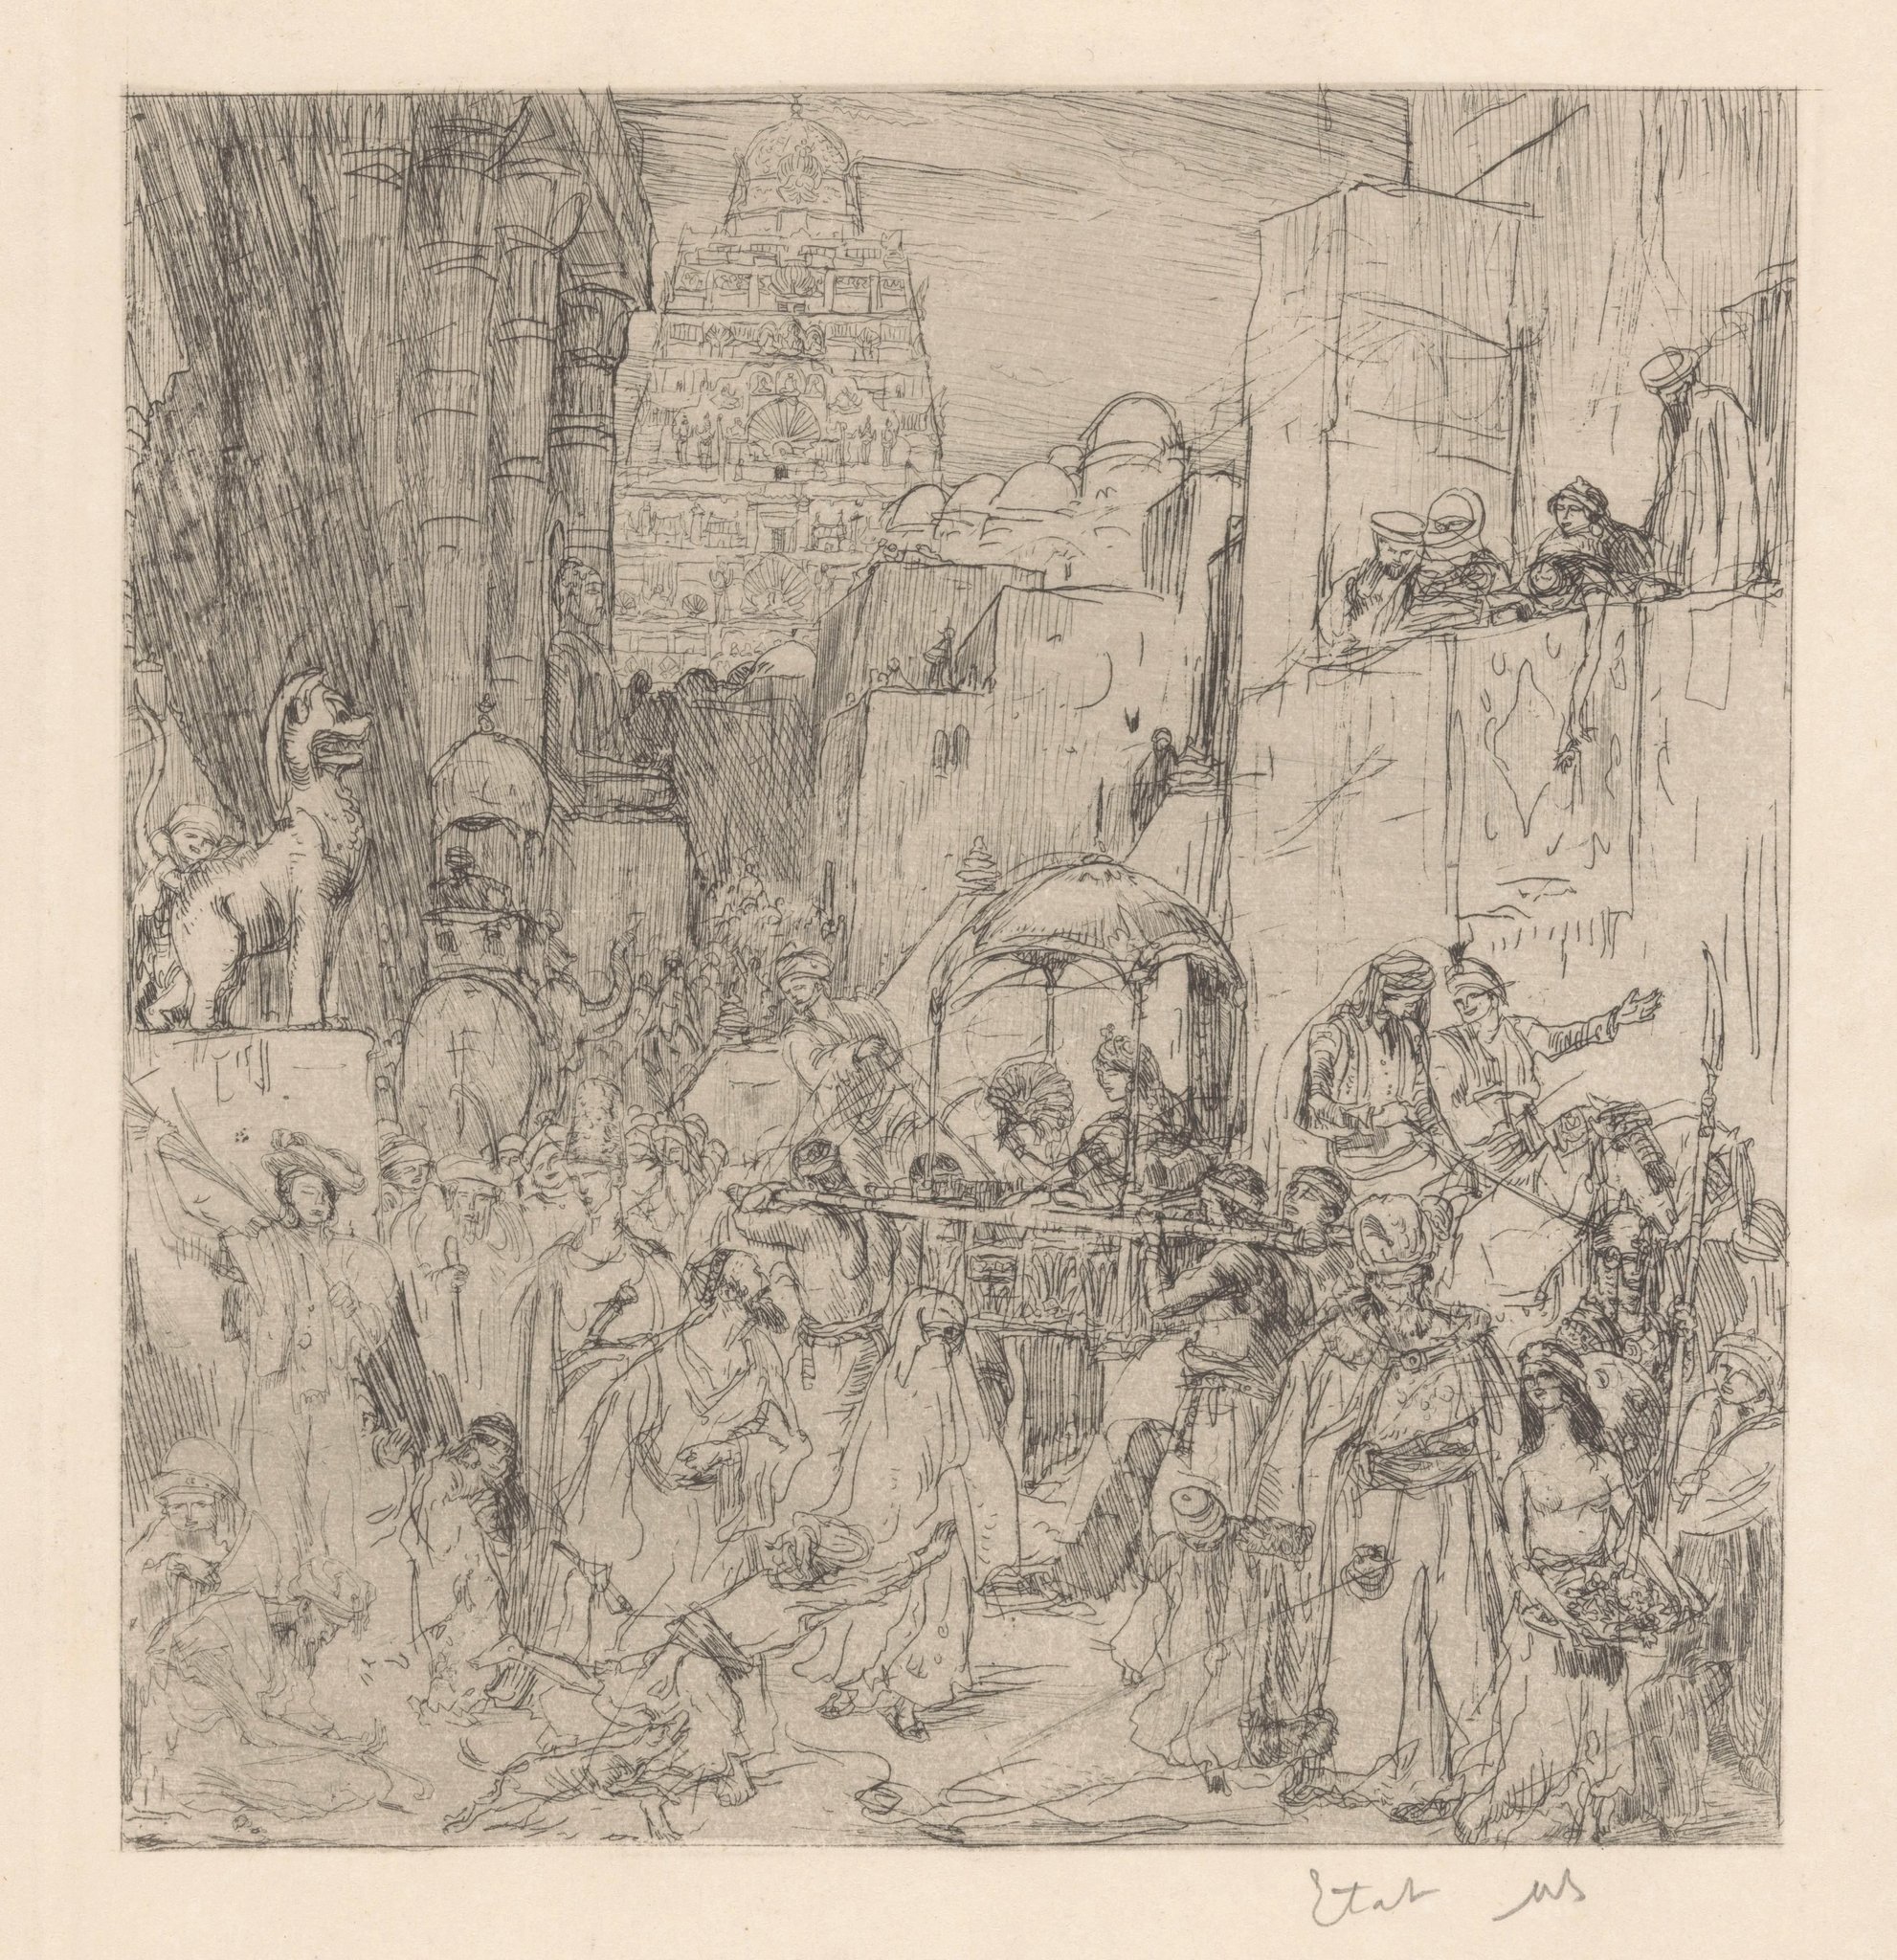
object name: print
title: La multitude emplissait d'une allégresse grave les rues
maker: marius bauer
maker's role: draughtsman, print maker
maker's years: 1867-1932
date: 1894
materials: paper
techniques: etching, intaglio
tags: (carrying a person on a) litter, stretcher, street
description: Een vrouw wordt door vier mannen over straat vervoerd in een draagkoets. Om de koets heen bevindt zich een menigte mensen, waaronder twee ruiters te paard, figuren die een olifant berijden, een gesluierde vrouw en een bedelaar. Op de achtergrond een tempel.